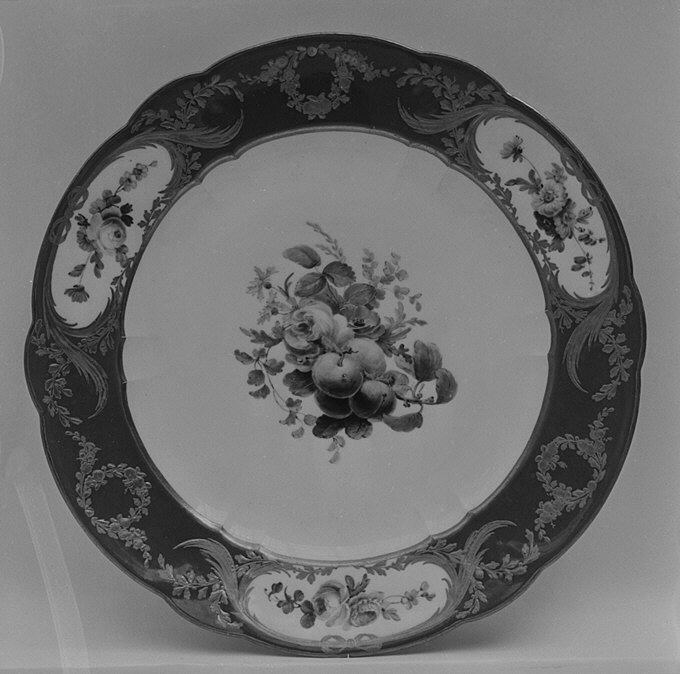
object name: plate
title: Plate (part of a service)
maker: sèvres manufactory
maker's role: manufactory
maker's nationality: french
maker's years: 1740-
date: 1784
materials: soft paste porcelain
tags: fruit,flowers